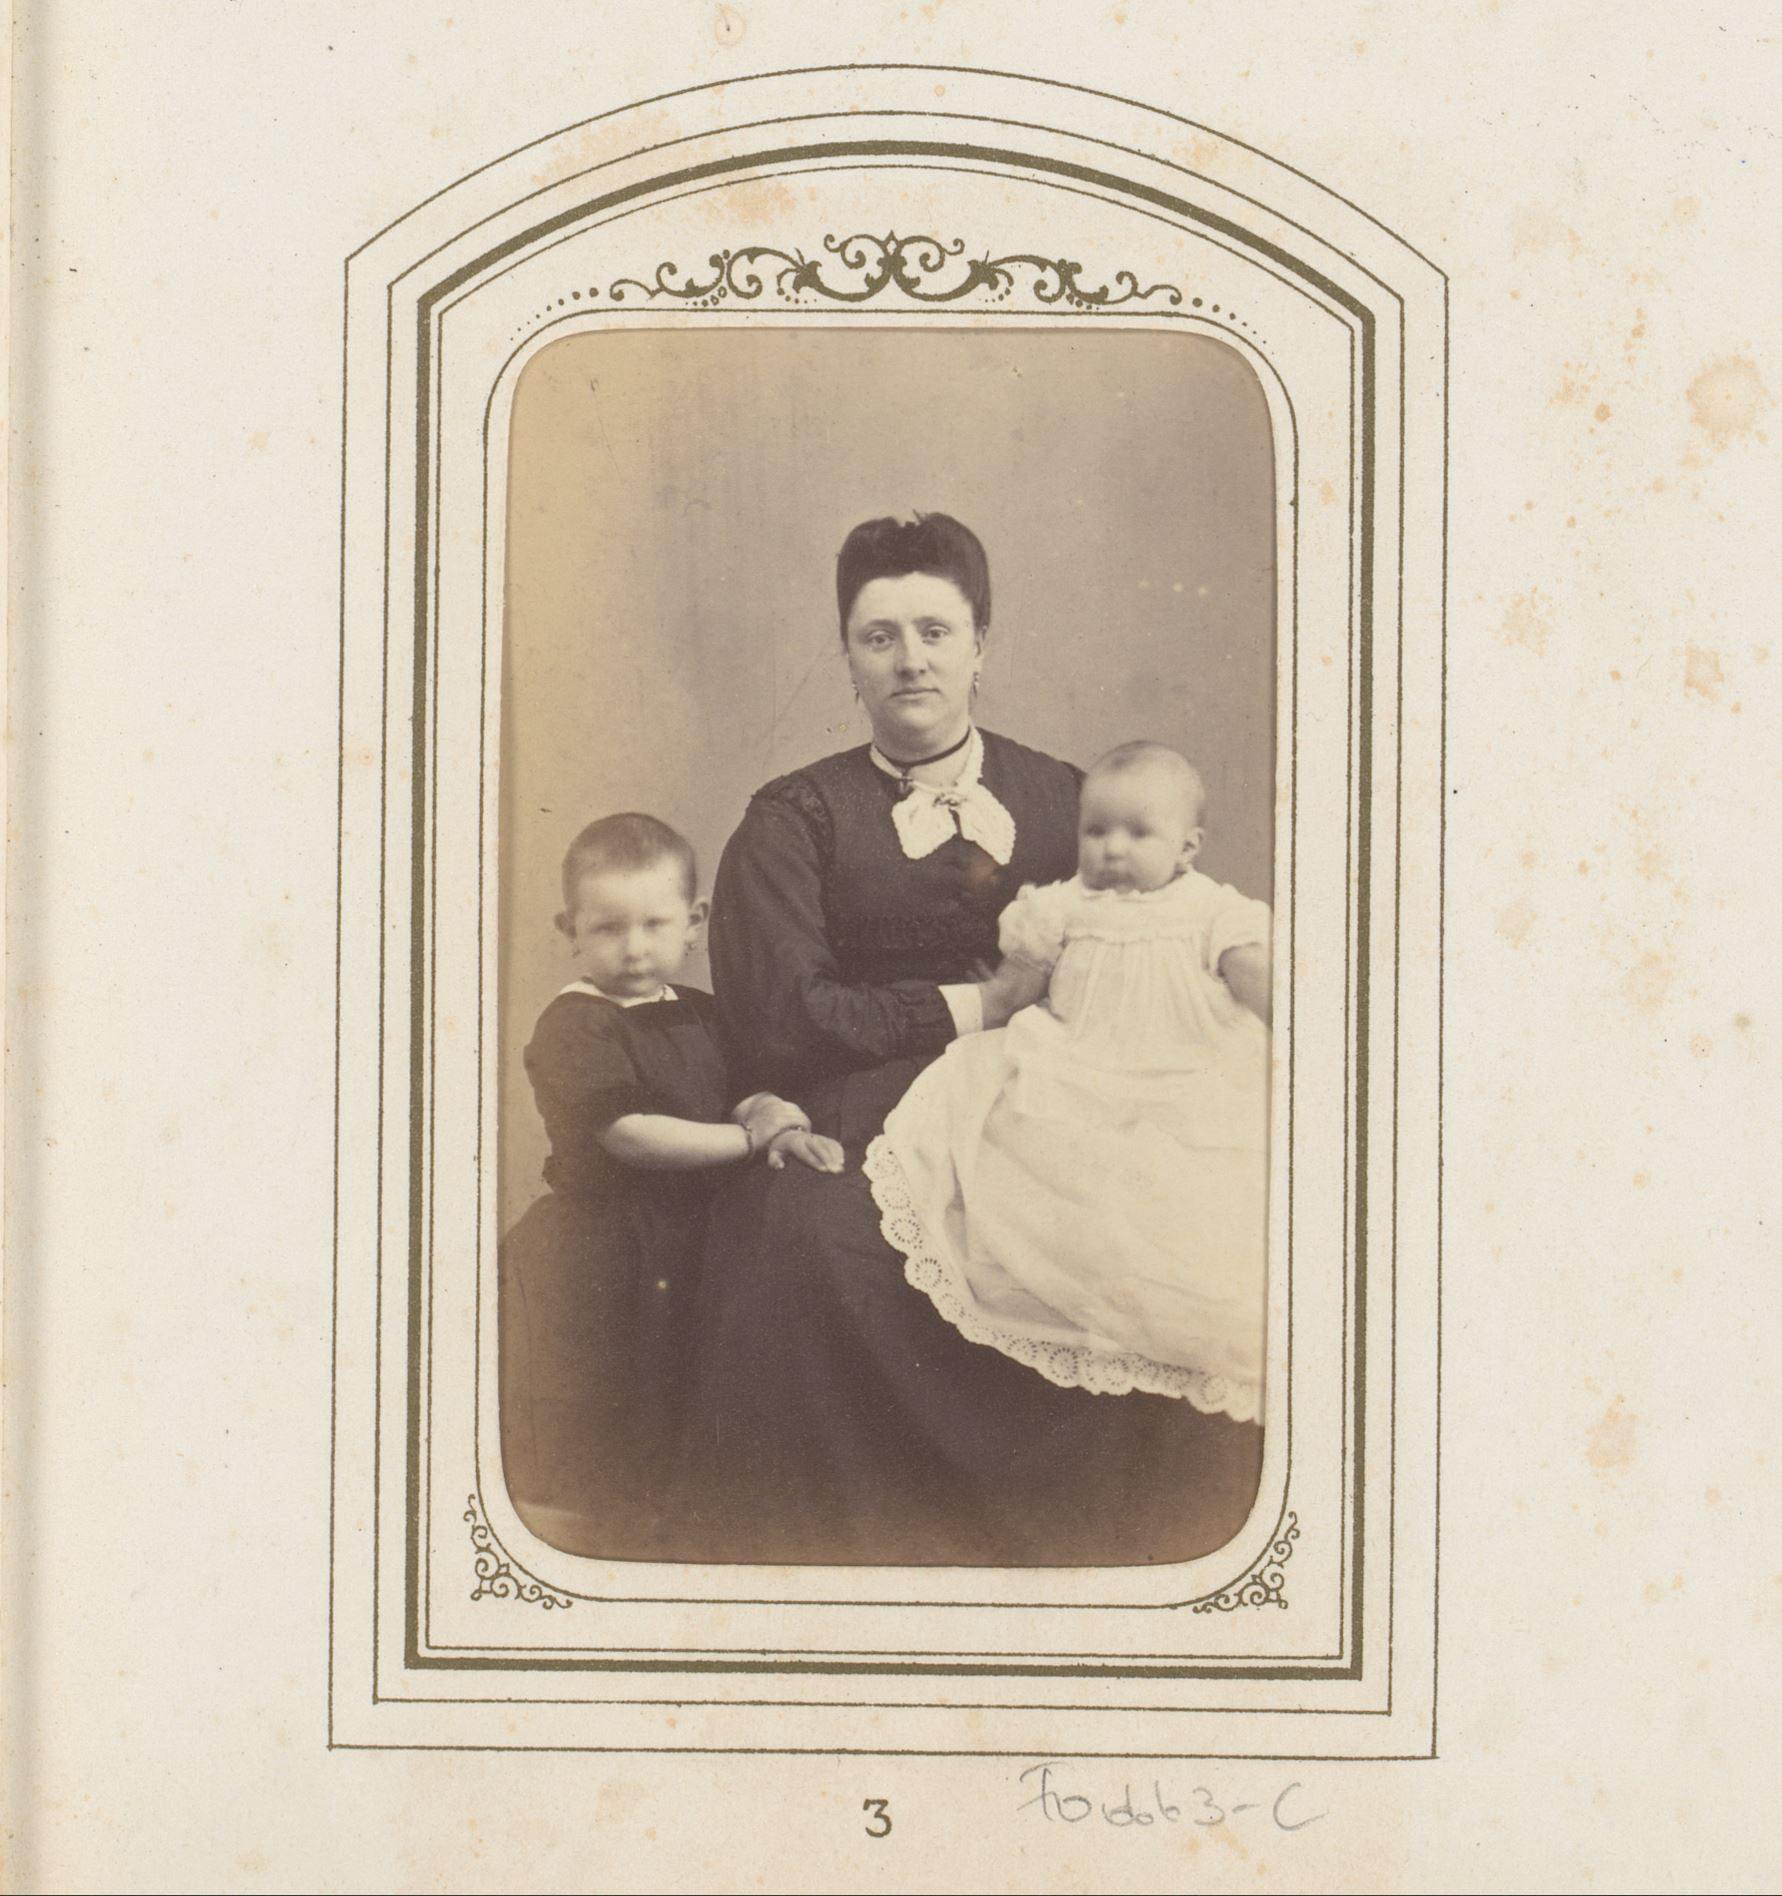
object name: album leaf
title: Portret van een vrouw met twee kinderen, Jette, Augusta en Bartina Harmens, de baby draagt een doopjurk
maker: hermanus siderius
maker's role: draughtsman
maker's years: 1819-1892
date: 1860-1880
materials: cardboard, photographic support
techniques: albumen print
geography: harlingen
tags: historical persons, mother and child(ren), woman and child(ren) (family group)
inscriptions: annotation: ‘Jette Harmens/ geb: Wybenga/ Augusta en Bartina’, number: ‘3’, workshop stamp: ‘H. Siderius/ Harlingen’